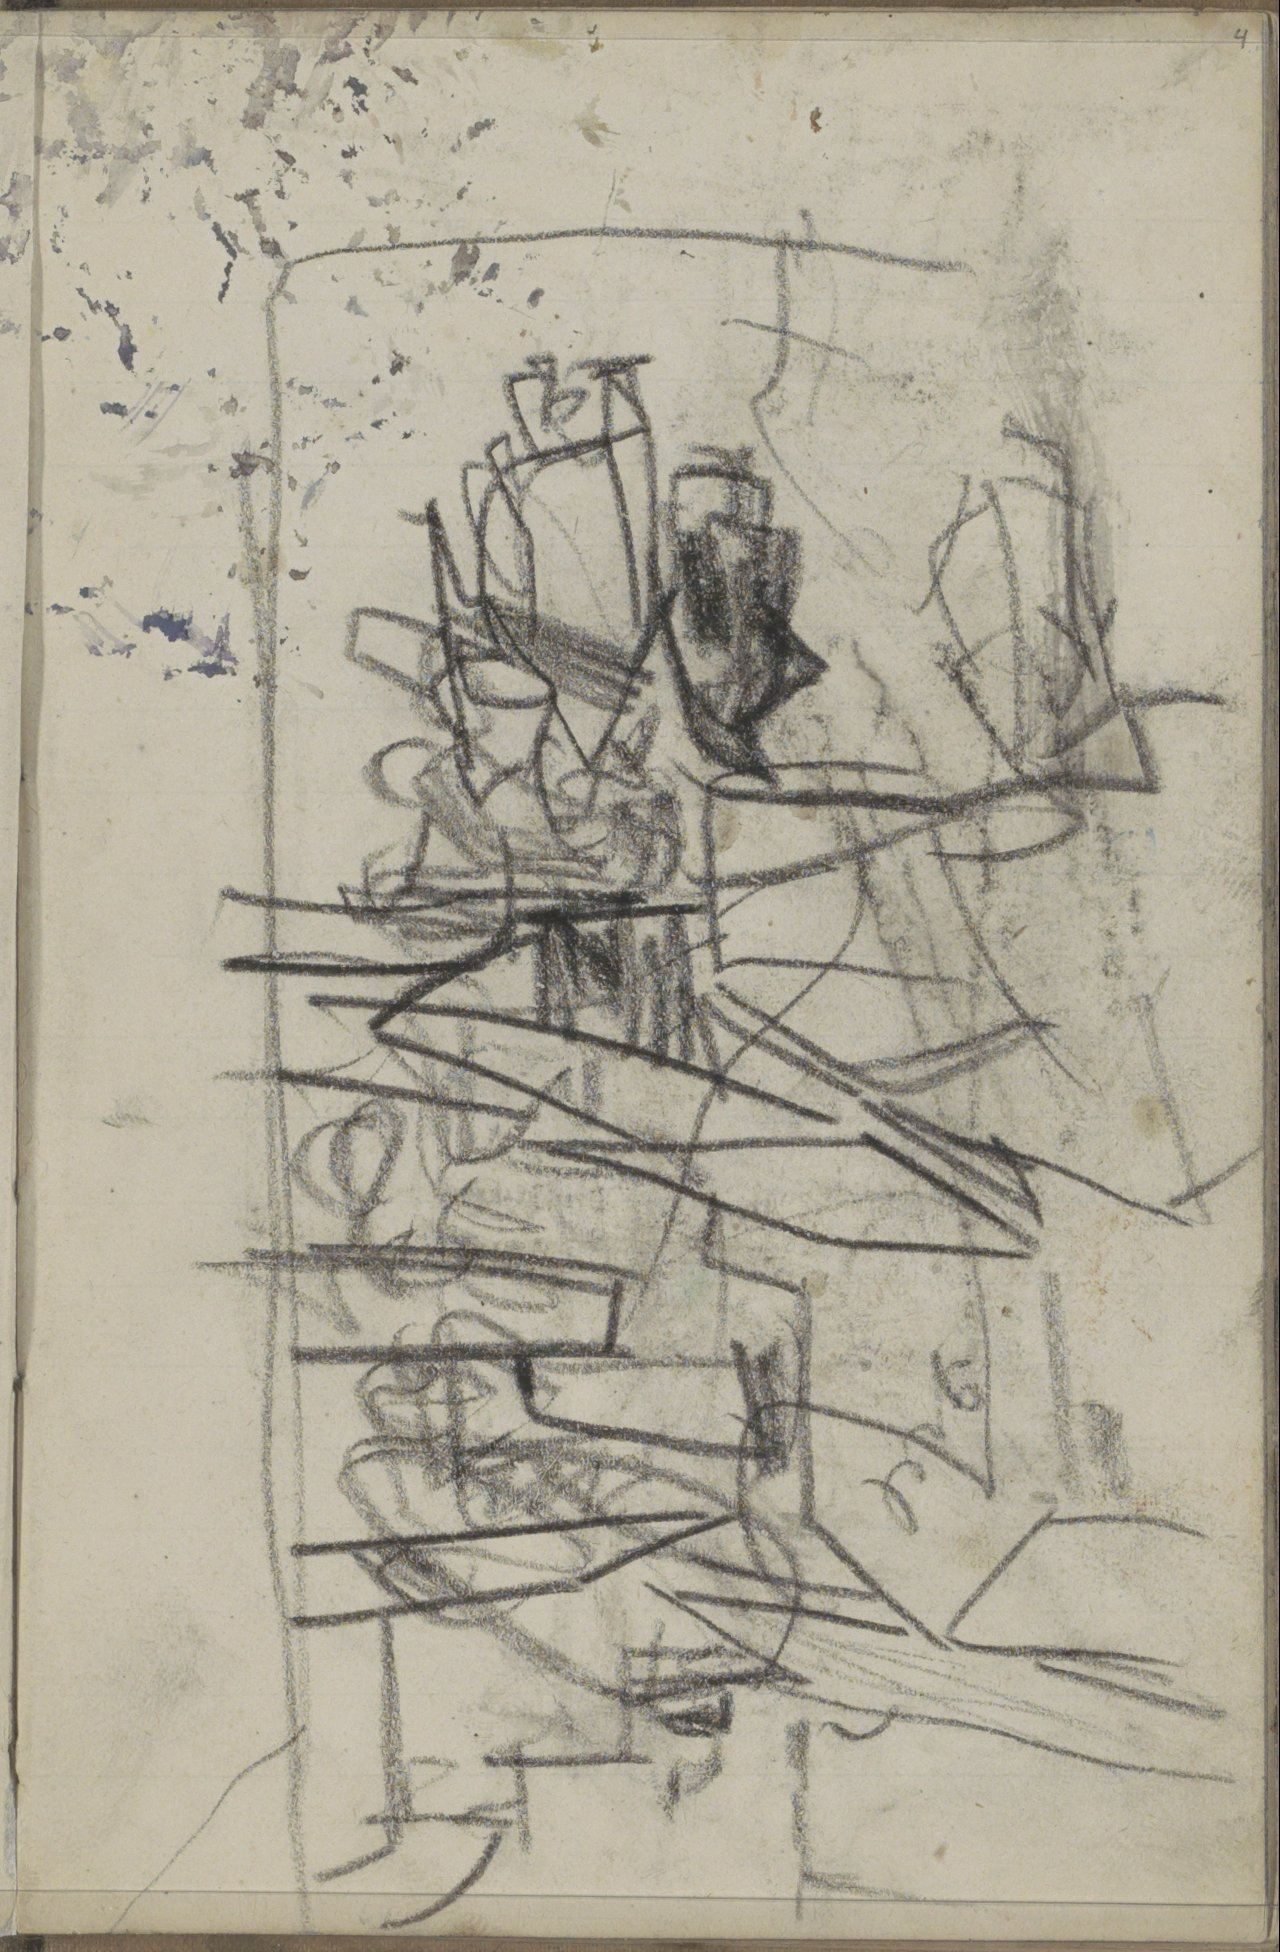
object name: sketchbook leaf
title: Studieblad met figuren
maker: marius bauer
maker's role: draughtsman, print maker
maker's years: 1867-1932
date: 1888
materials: chalk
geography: istanbul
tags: anatomy (non-medical)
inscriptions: kleurnotitie, handgeschreven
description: Pagina 4 uit een schetsboek met 56 bladen.